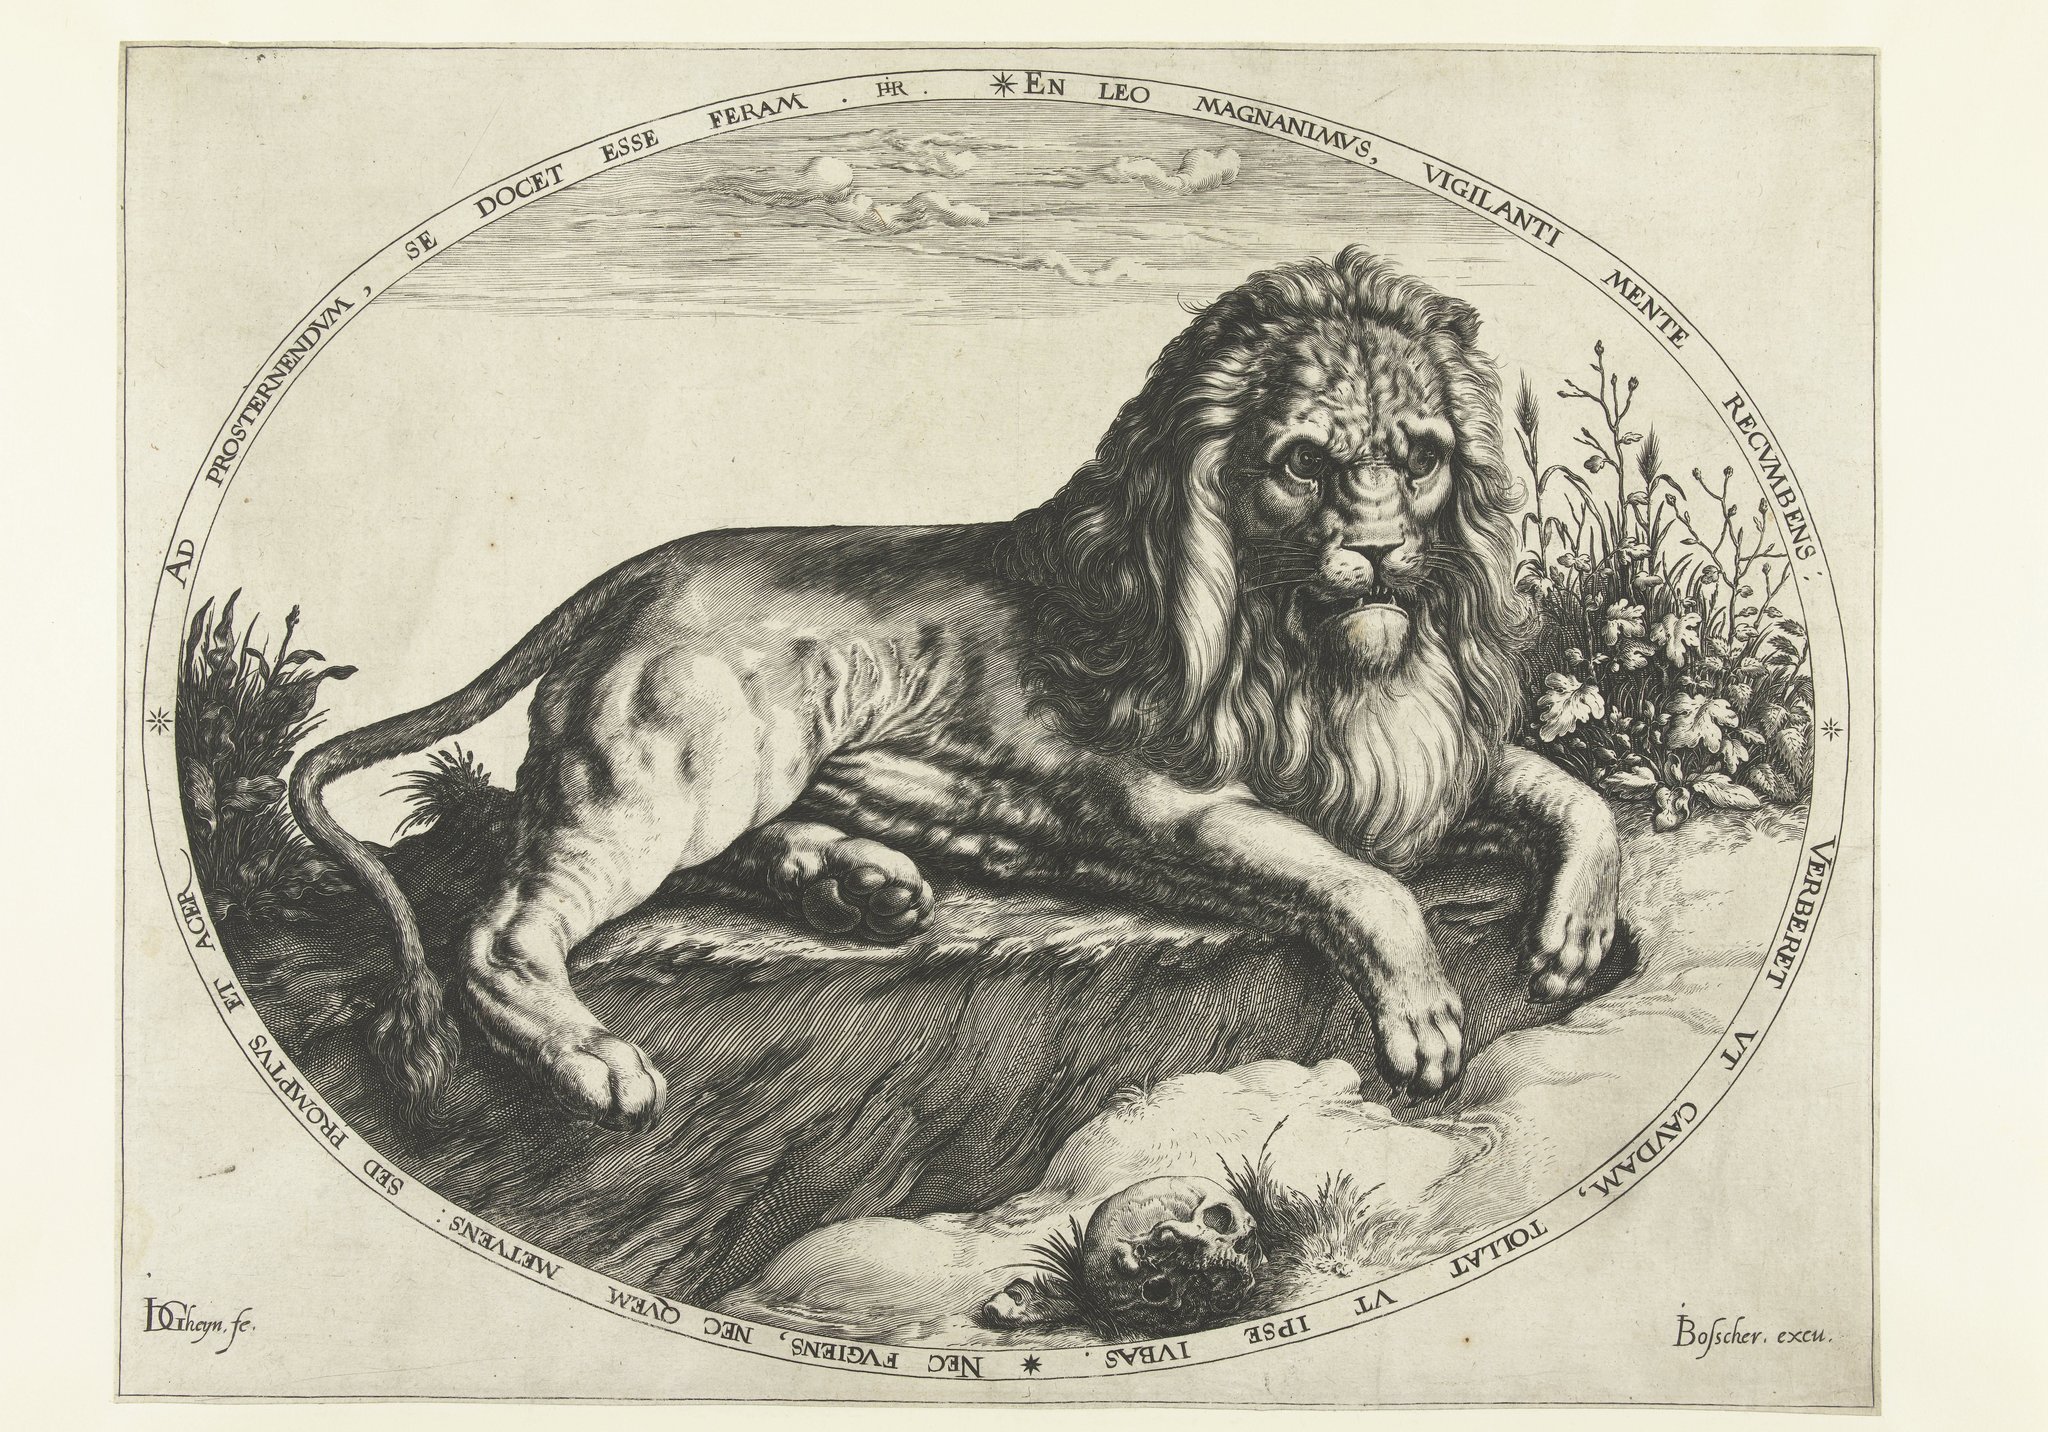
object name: print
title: De leeuw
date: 1588-1592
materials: paper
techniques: engraving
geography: netherlands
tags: (human) skull, beasts of prey, predatory animals: lion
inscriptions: collector's mark: Lugt 2228, collector's mark: Lugt 2760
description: Ovale voorstelling van een leeuw, liggend bij een schedel. Om de voorstelling een Latijns randschrift.